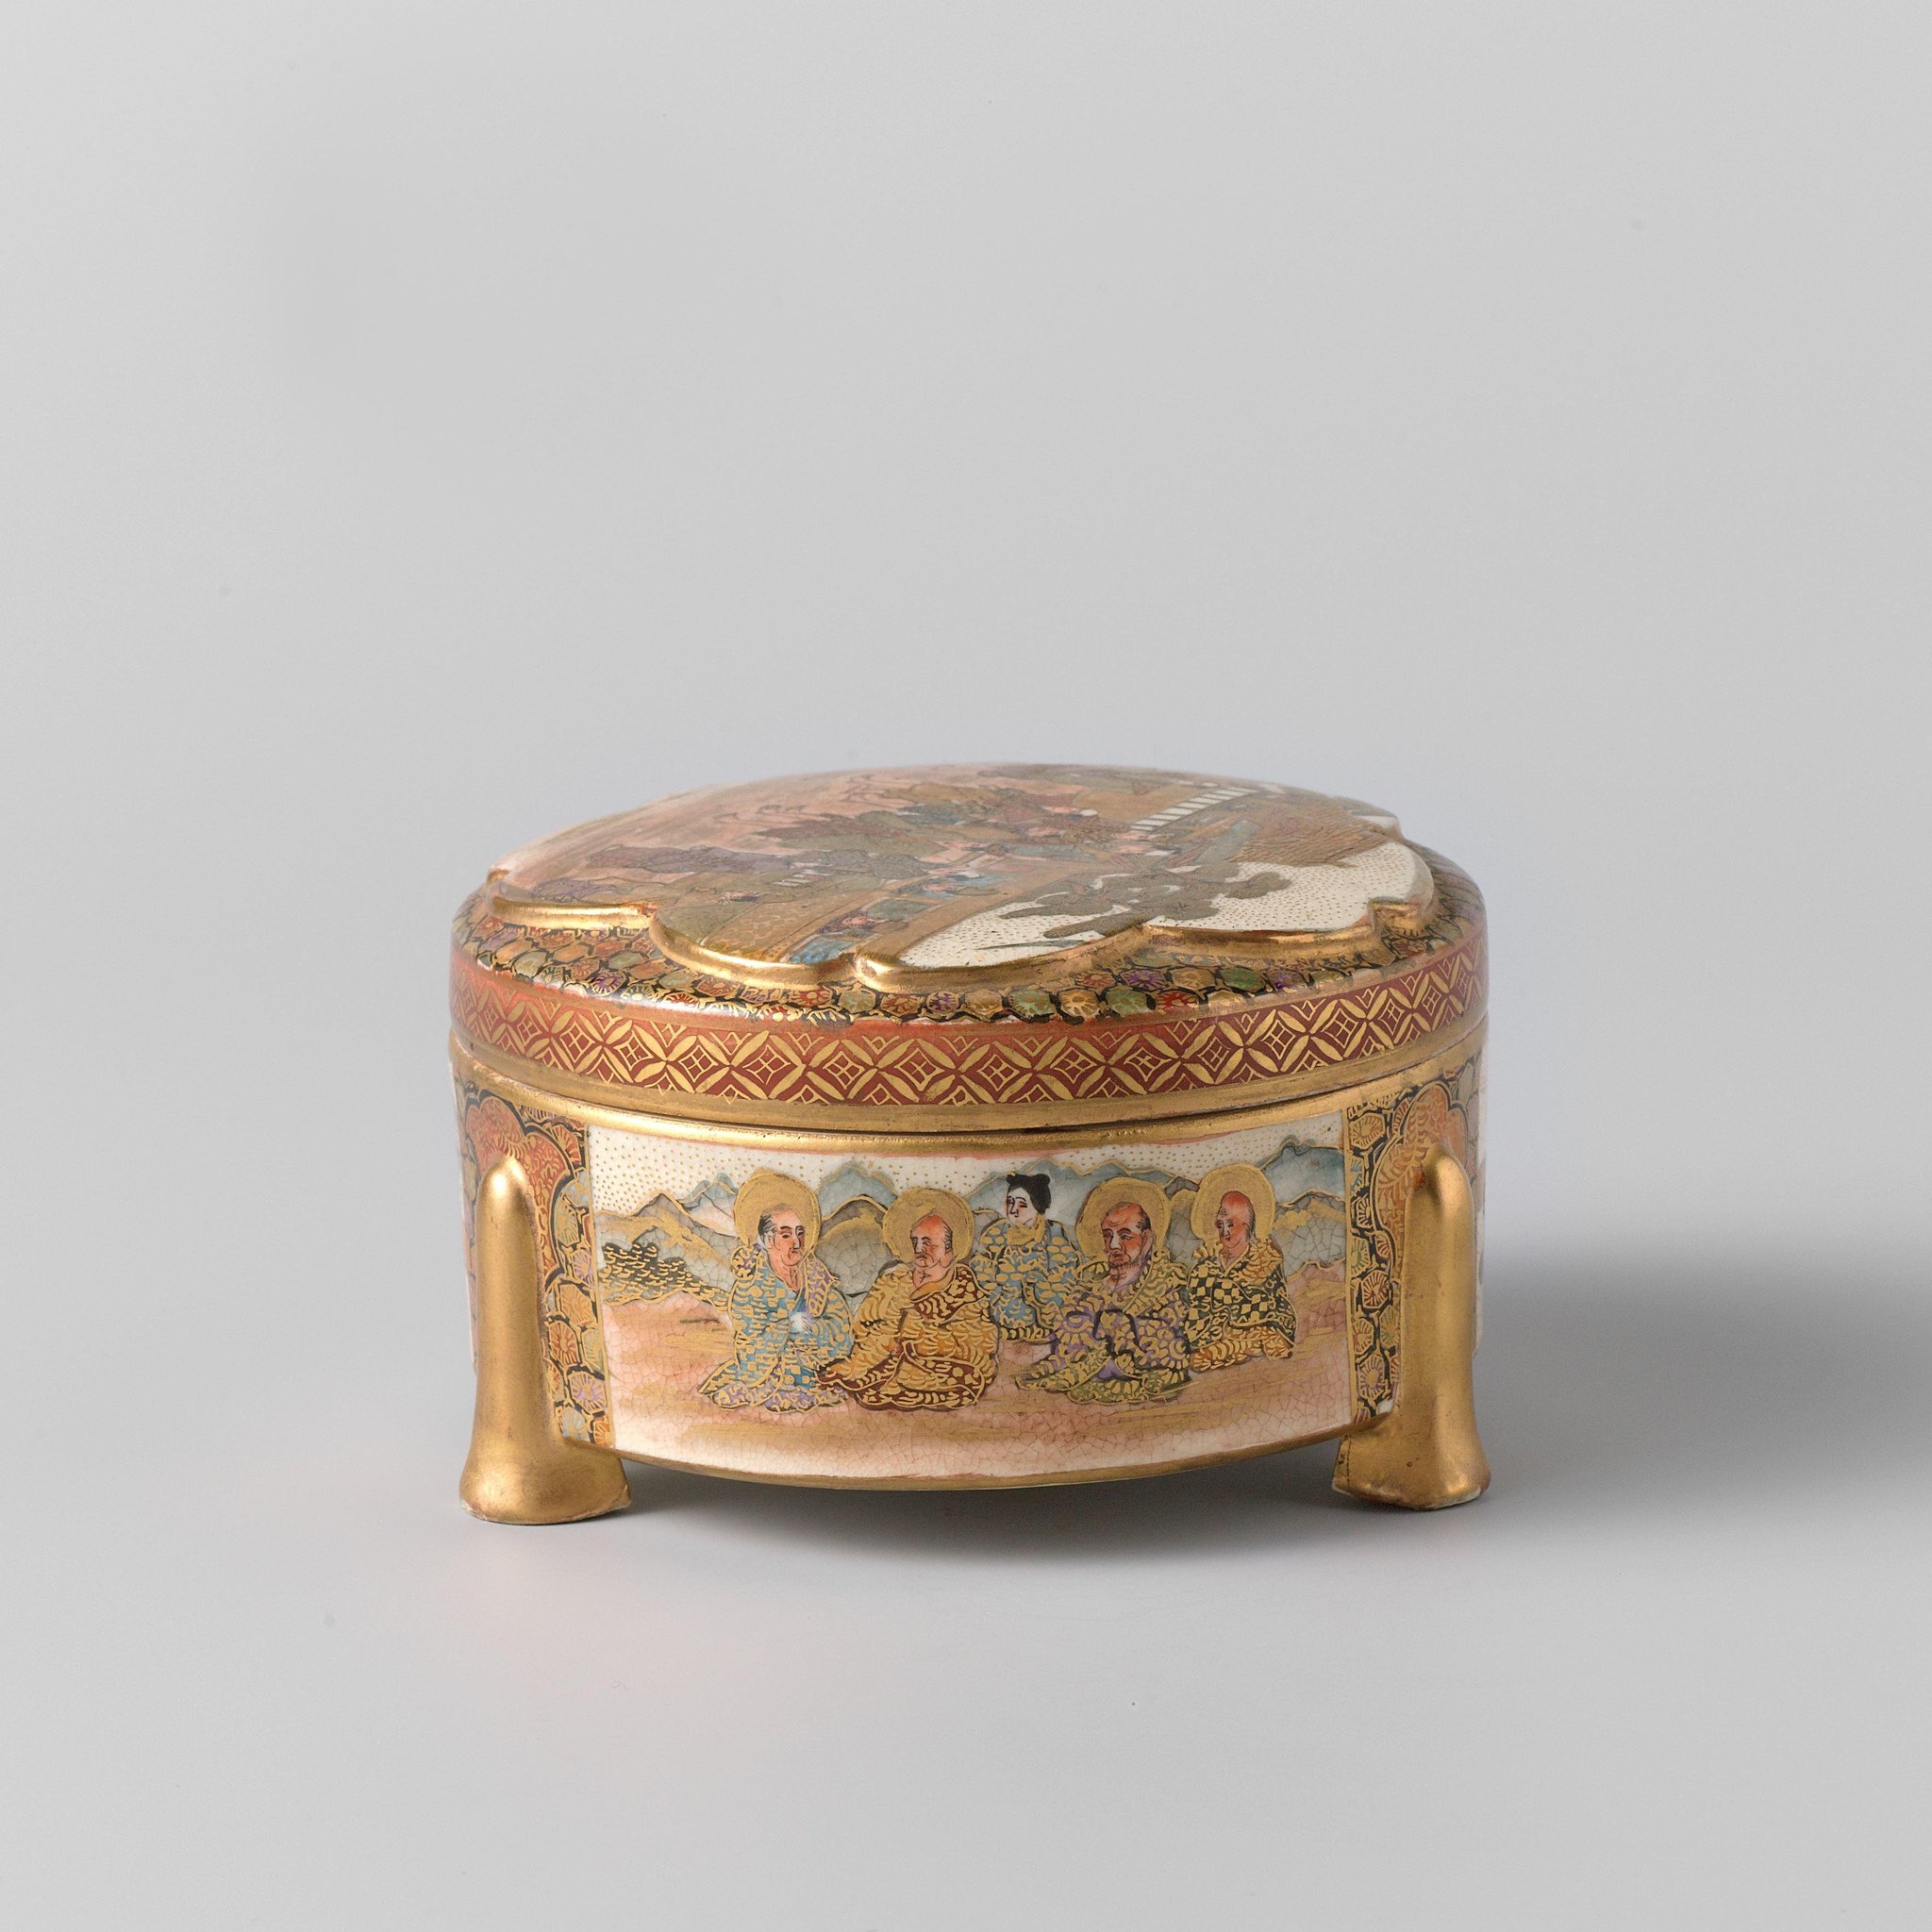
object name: box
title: Round box with figures on a terras or in a landscape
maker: Anonymous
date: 1800-1899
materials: glaze, gold, paint, stoneware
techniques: firing, gilding, turning, vitrification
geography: japan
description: Deksel van ronde doos van steengoed, beschilderd op het glazuur in blauw, rood, groen, paars, bruin, zwart en goud. De deksel met een gemodelleerd, gelobd cartouche met een optocht van mannen met een draagkist, lopend voor een paviljoen. Om het cartouche en op de rand servetwerk. Satsuma.